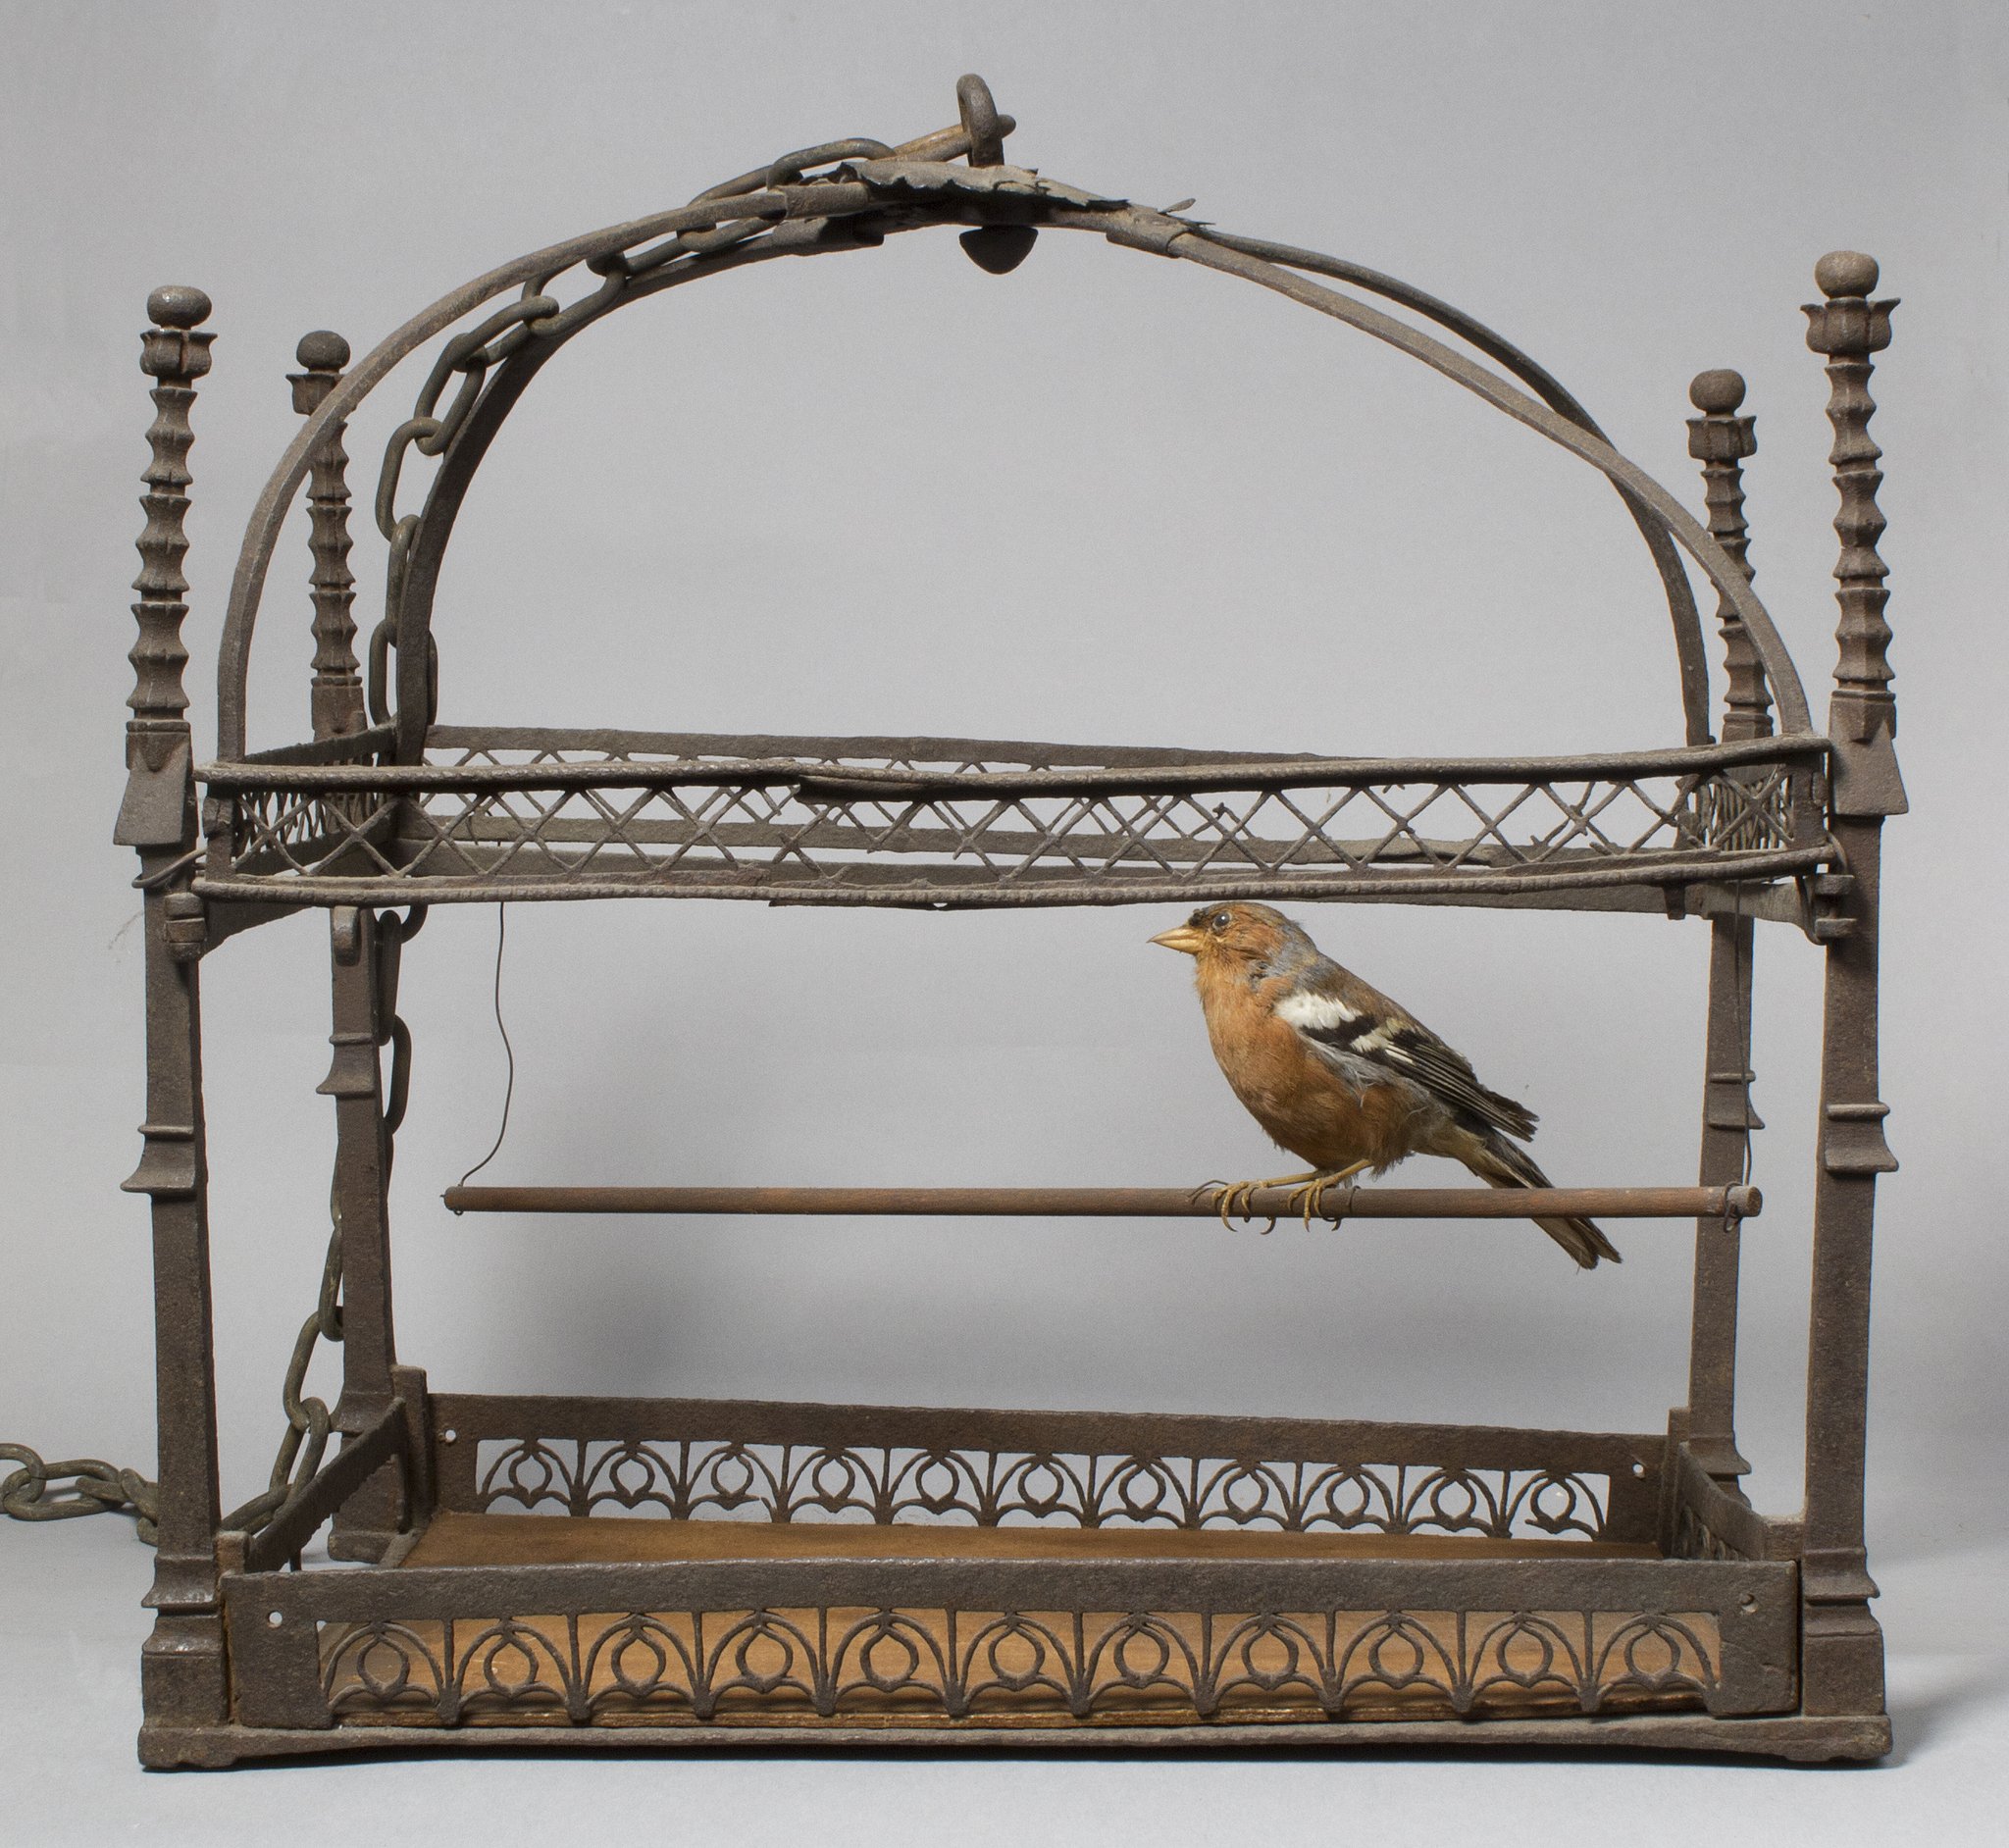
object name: birdcage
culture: south french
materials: iron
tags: birds